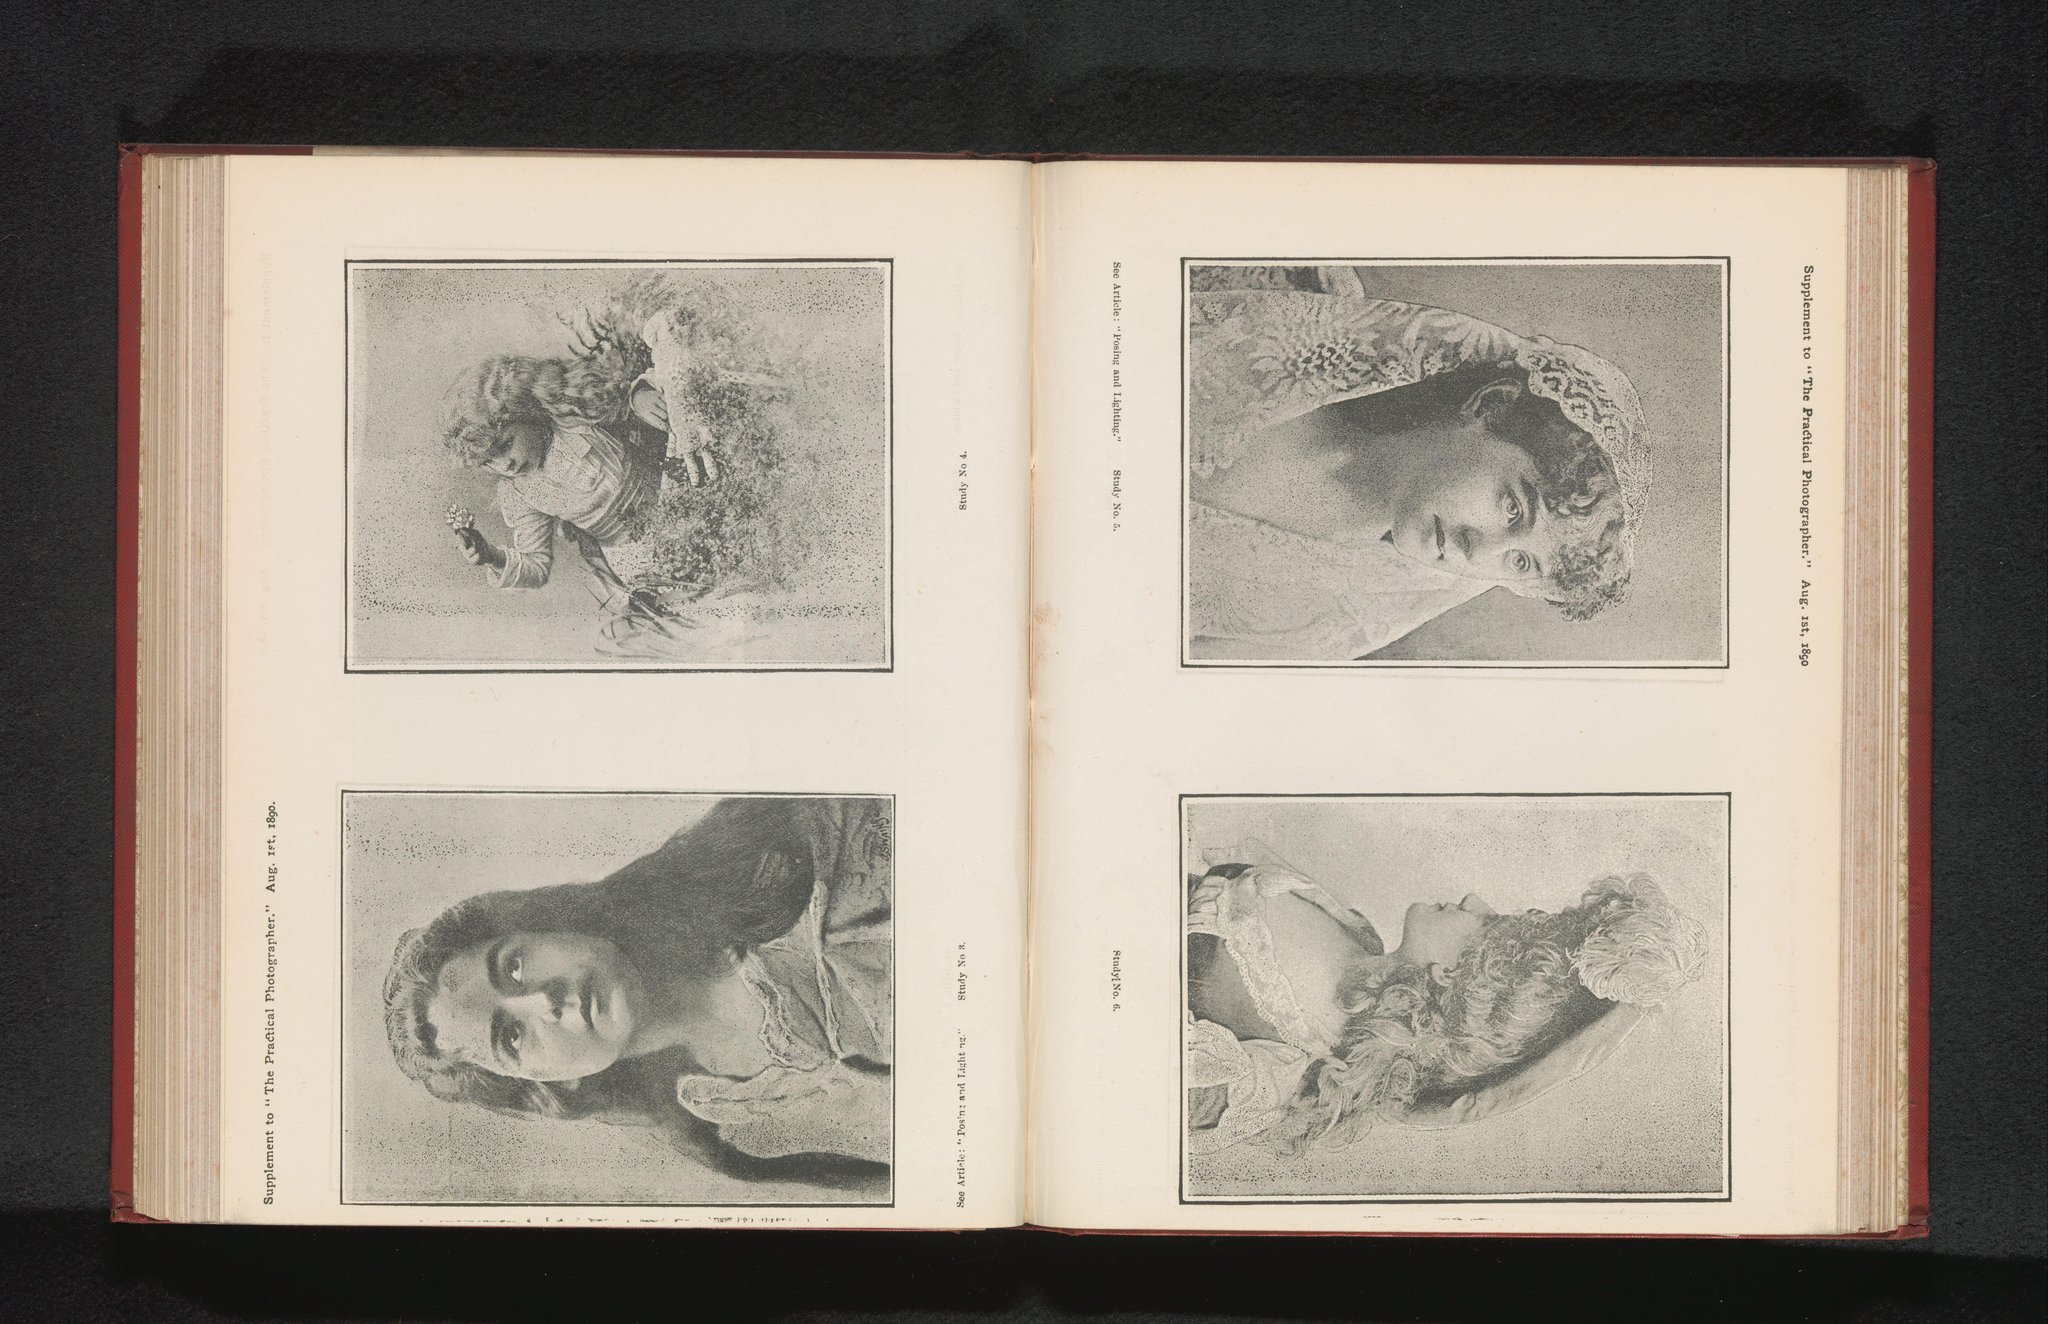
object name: page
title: Twee voorbeelden van portretten van onbekende jonge meisjes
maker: Anonymous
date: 1885-1890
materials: paper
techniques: autotype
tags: adolescent, young woman, maiden, historical persons not known by name - bb - woman, girl (child between toddler and youth)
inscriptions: inscription: ‘Study No. 3.’, inscription: ‘See Article: "Posing and Lighting."’, inscription: ‘Study No. 4.’, inscription: ‘Supplement to "The Practical Photographer." Aug. 1st, 1890.’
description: Prenten op zesde ongenummerde pagina na pagina 182.